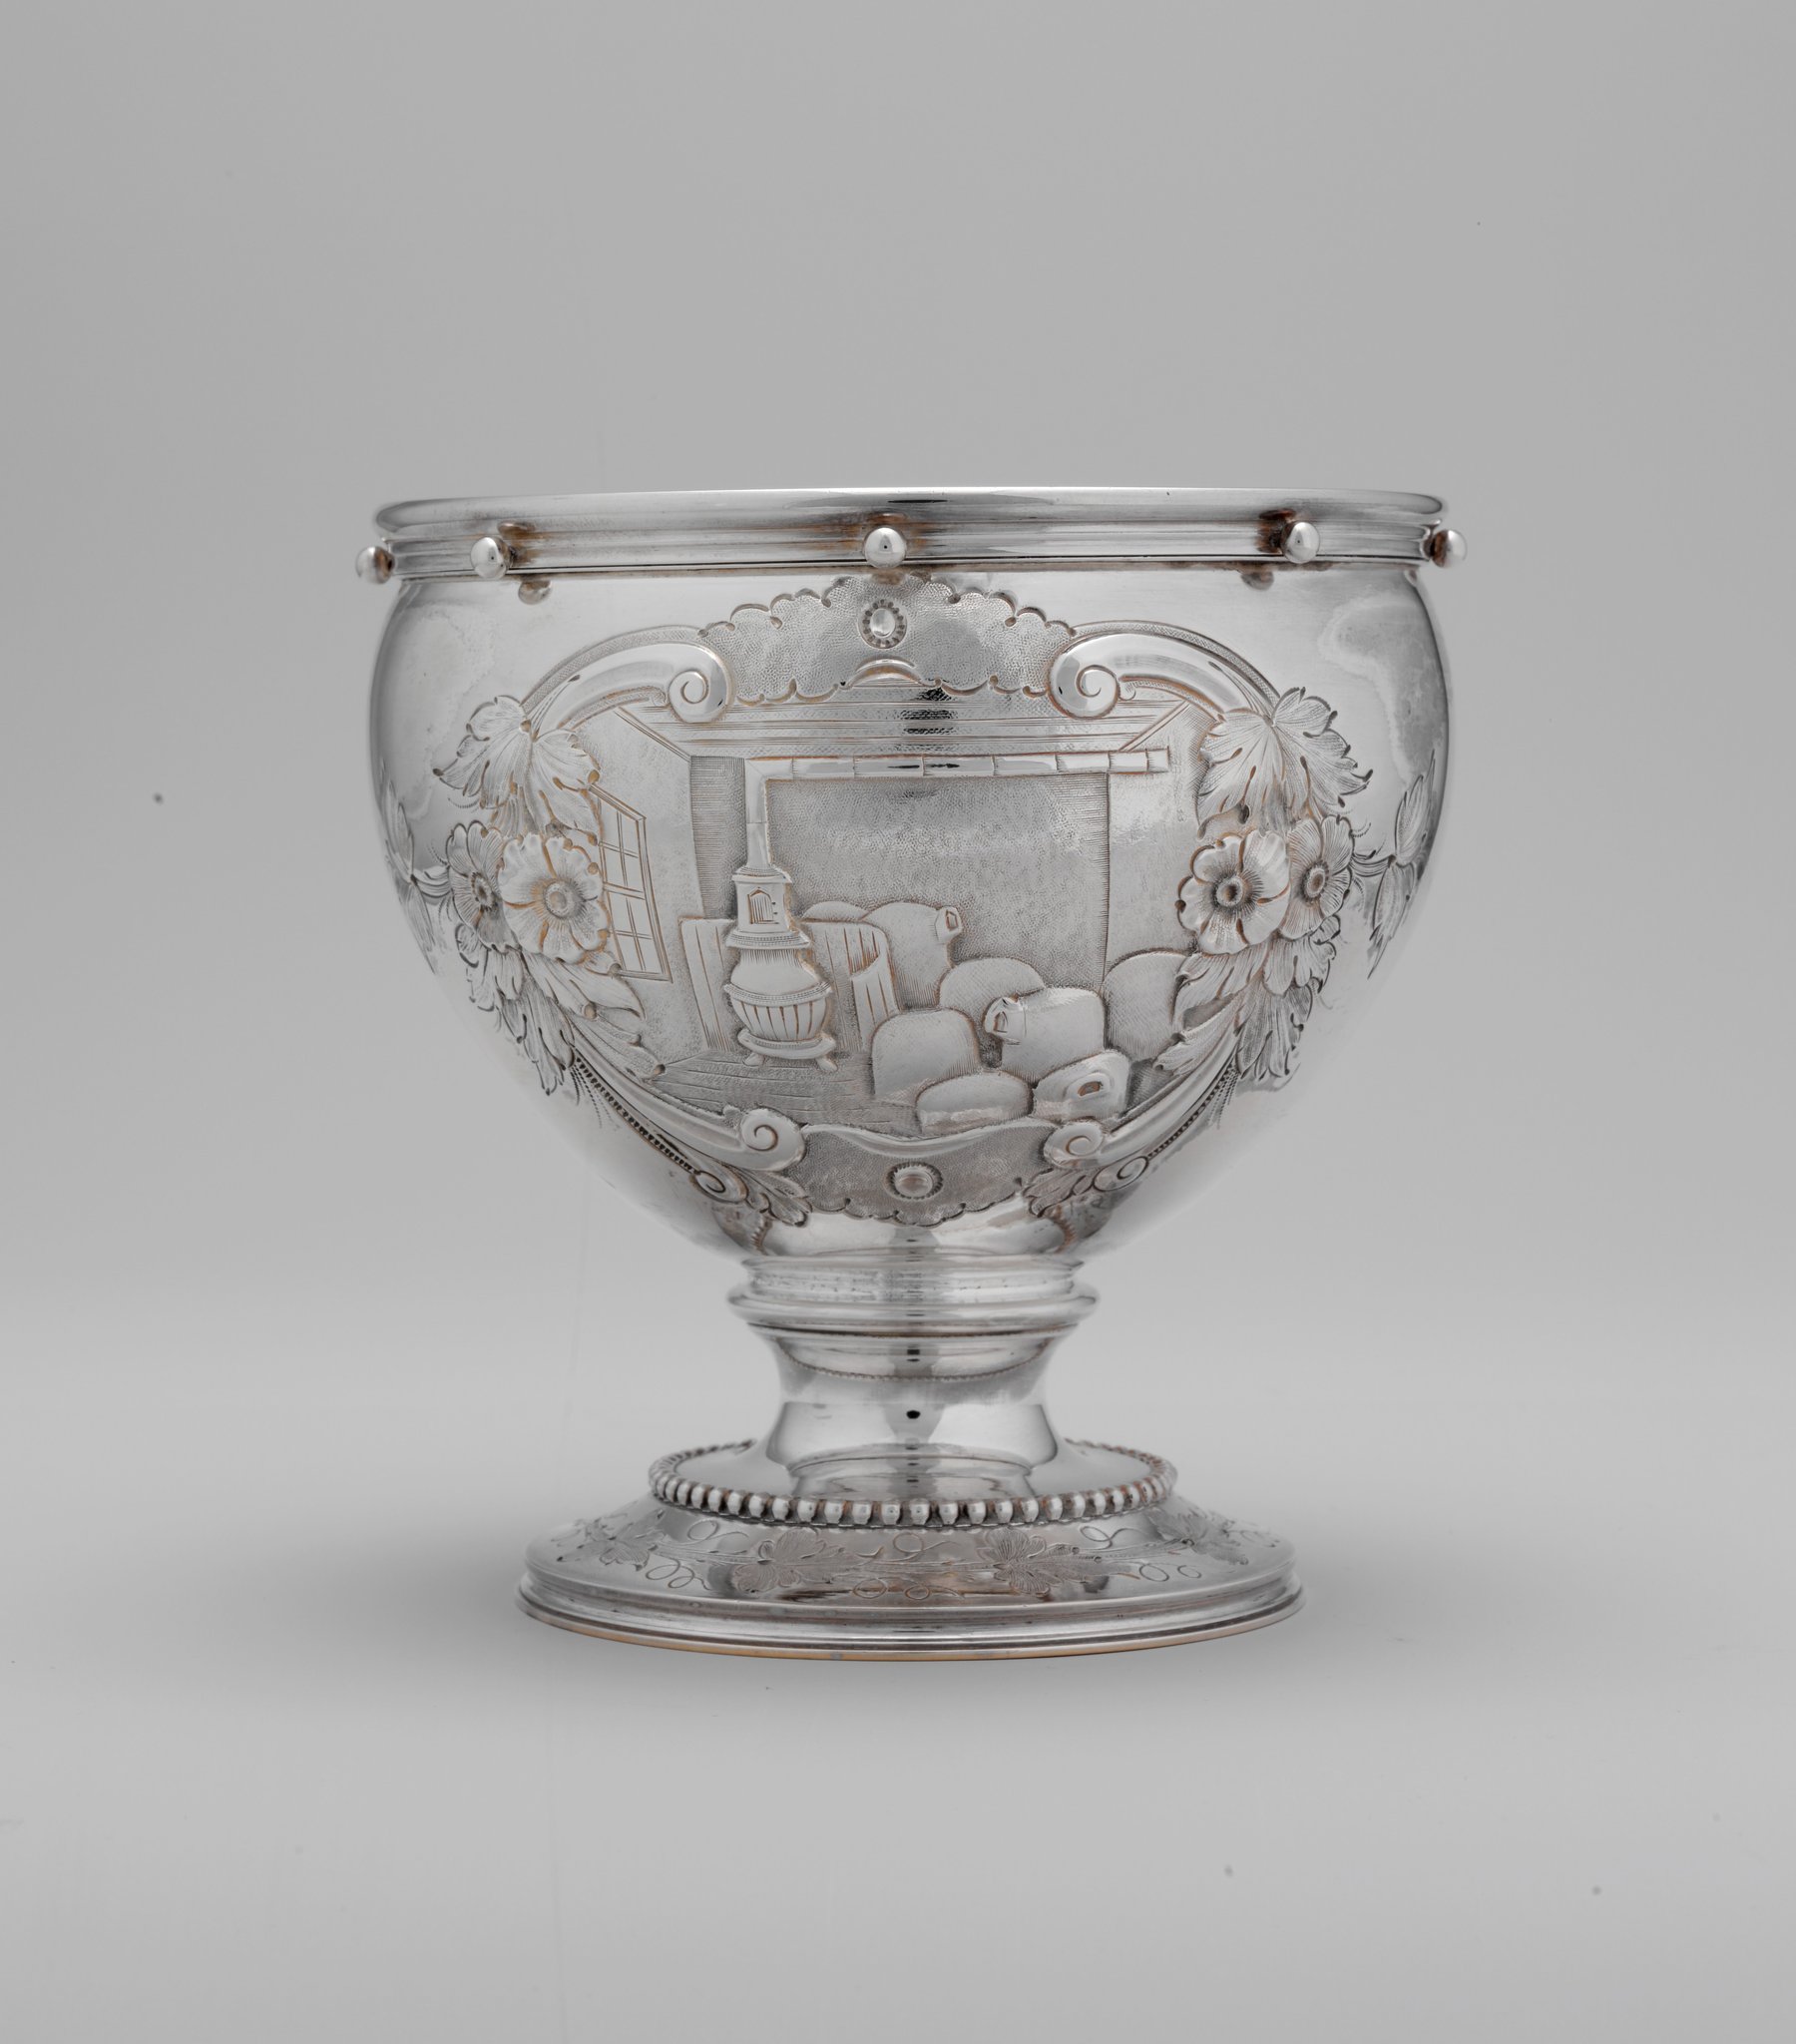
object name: waste bowl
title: Slop bowl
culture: american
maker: wood and hughes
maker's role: maker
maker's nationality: american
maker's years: 1845-1899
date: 1862-1863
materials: silver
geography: united states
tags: factories